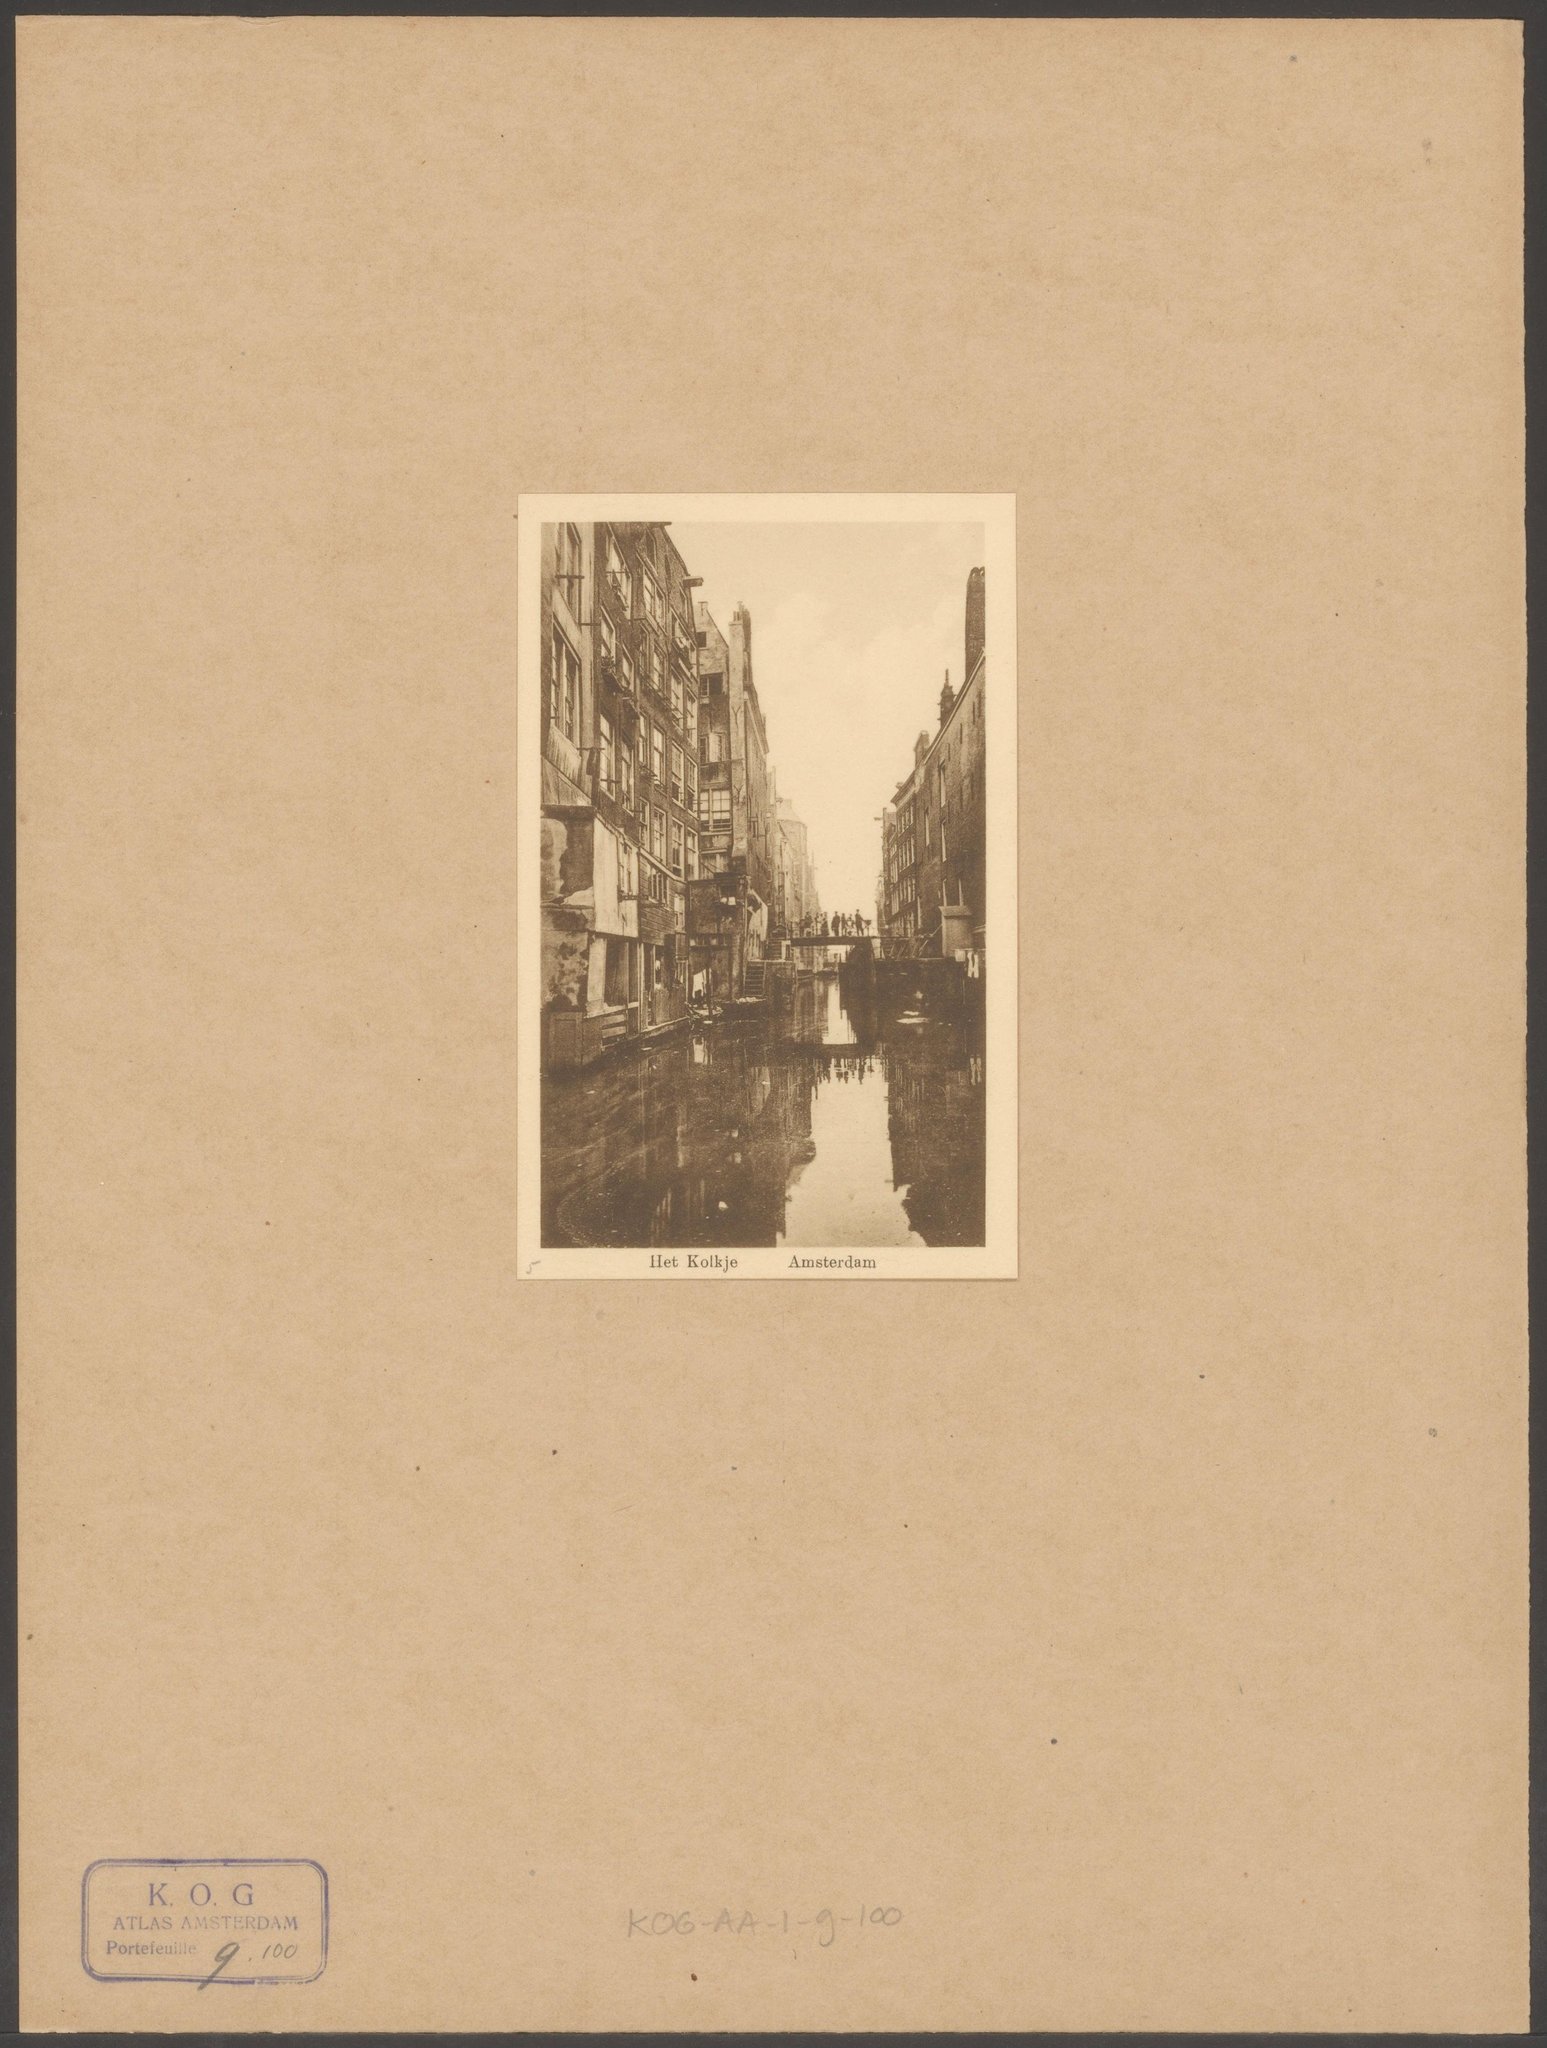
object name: photomechanical print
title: Gezicht op de Oudezijds Kolk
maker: Anonymous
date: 1905-1930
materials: cardboard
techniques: photograph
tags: city-view in general; 'veduta', canal, bridge in city across river, canal, etc., street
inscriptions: collector's mark: ‘9.100’ Lugt 1641b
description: Onderwerpsrubriek binnen de Atlas Amsterdam: Kadijksplein, Karthuizerkerkhof, Kattegat, Kattenburg, Kapelsteeg O.Z., Enge Kerksteeg, Kerkstraat, Kinkerstraat, Kolk O.Z., Koningsplein, Kromboomsloot [Krom Boomssloot], Kostverlorenkade, Kwakersdwarspad, Kalverstraat, Keizersgracht (v.d. Brouwersgracht – Amstel), Klerensloot (Gedempte), Klimopstraat, Kloveniersburgwal, Kraansluis.